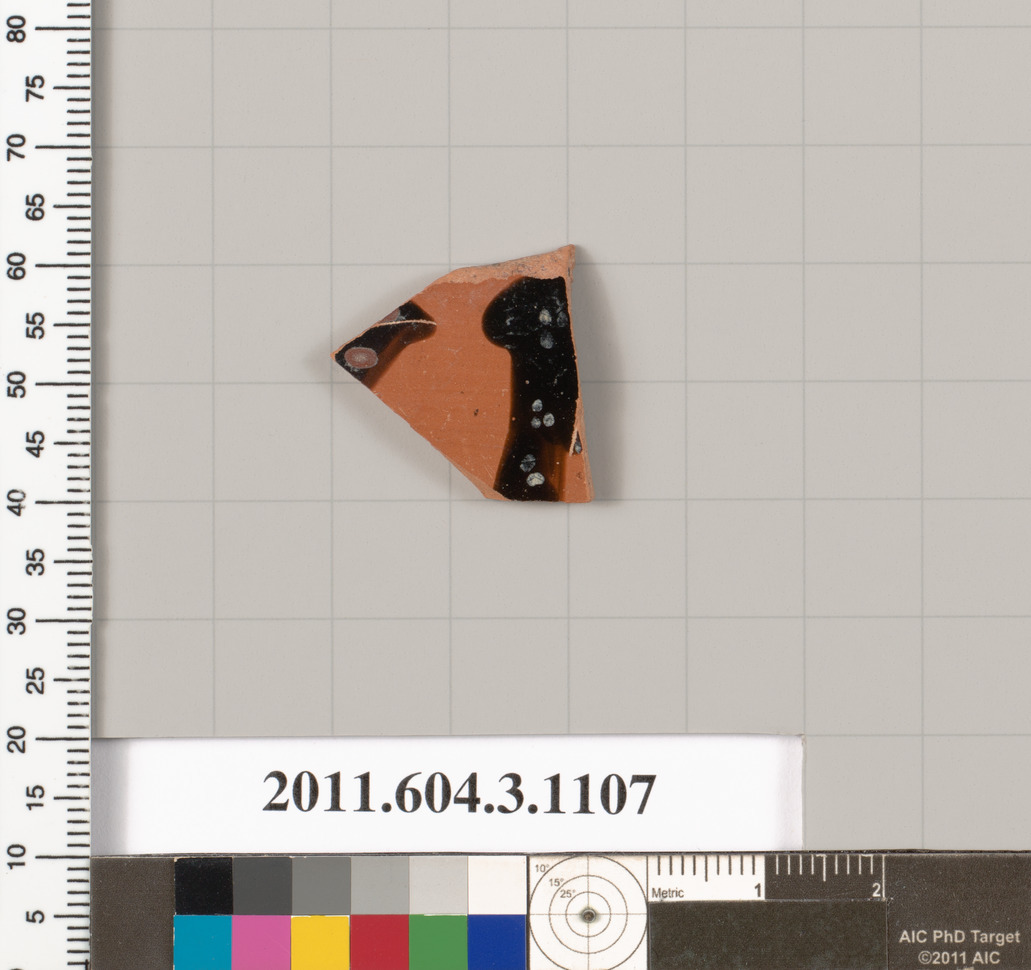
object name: mastoid or kyathos fragment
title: Terracotta fragment of a mastoid (drinking cup with narrow base) or a kyathos (cup-shaped ladle)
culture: greek, attic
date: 534-468 BCE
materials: terracotta